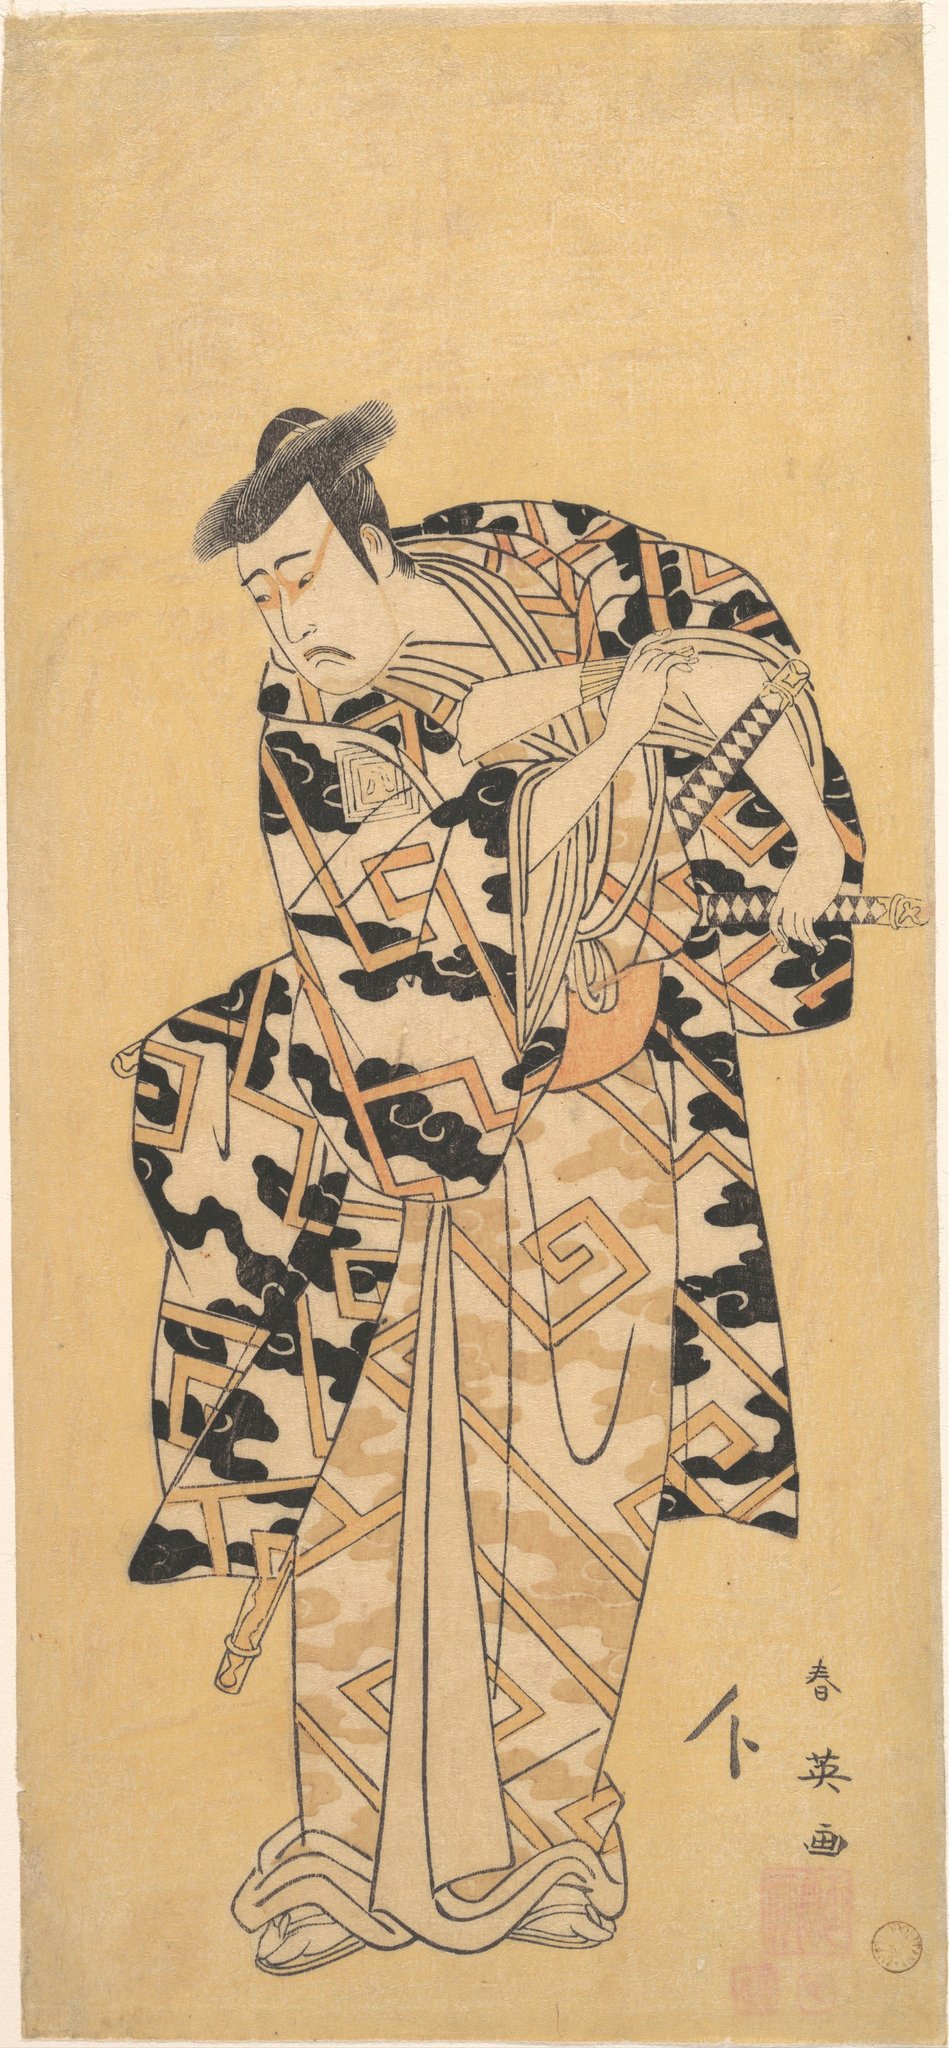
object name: woodblock print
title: The Actor Ichikawa Yaozō III as Fuwa Banzaemon in a Thunder Robe, Playing with a Fan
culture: japanese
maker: katsukawa shun'ei 勝川春英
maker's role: artist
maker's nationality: japanese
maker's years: 1762-1819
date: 1794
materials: ink, paper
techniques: woodblock print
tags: men,actors